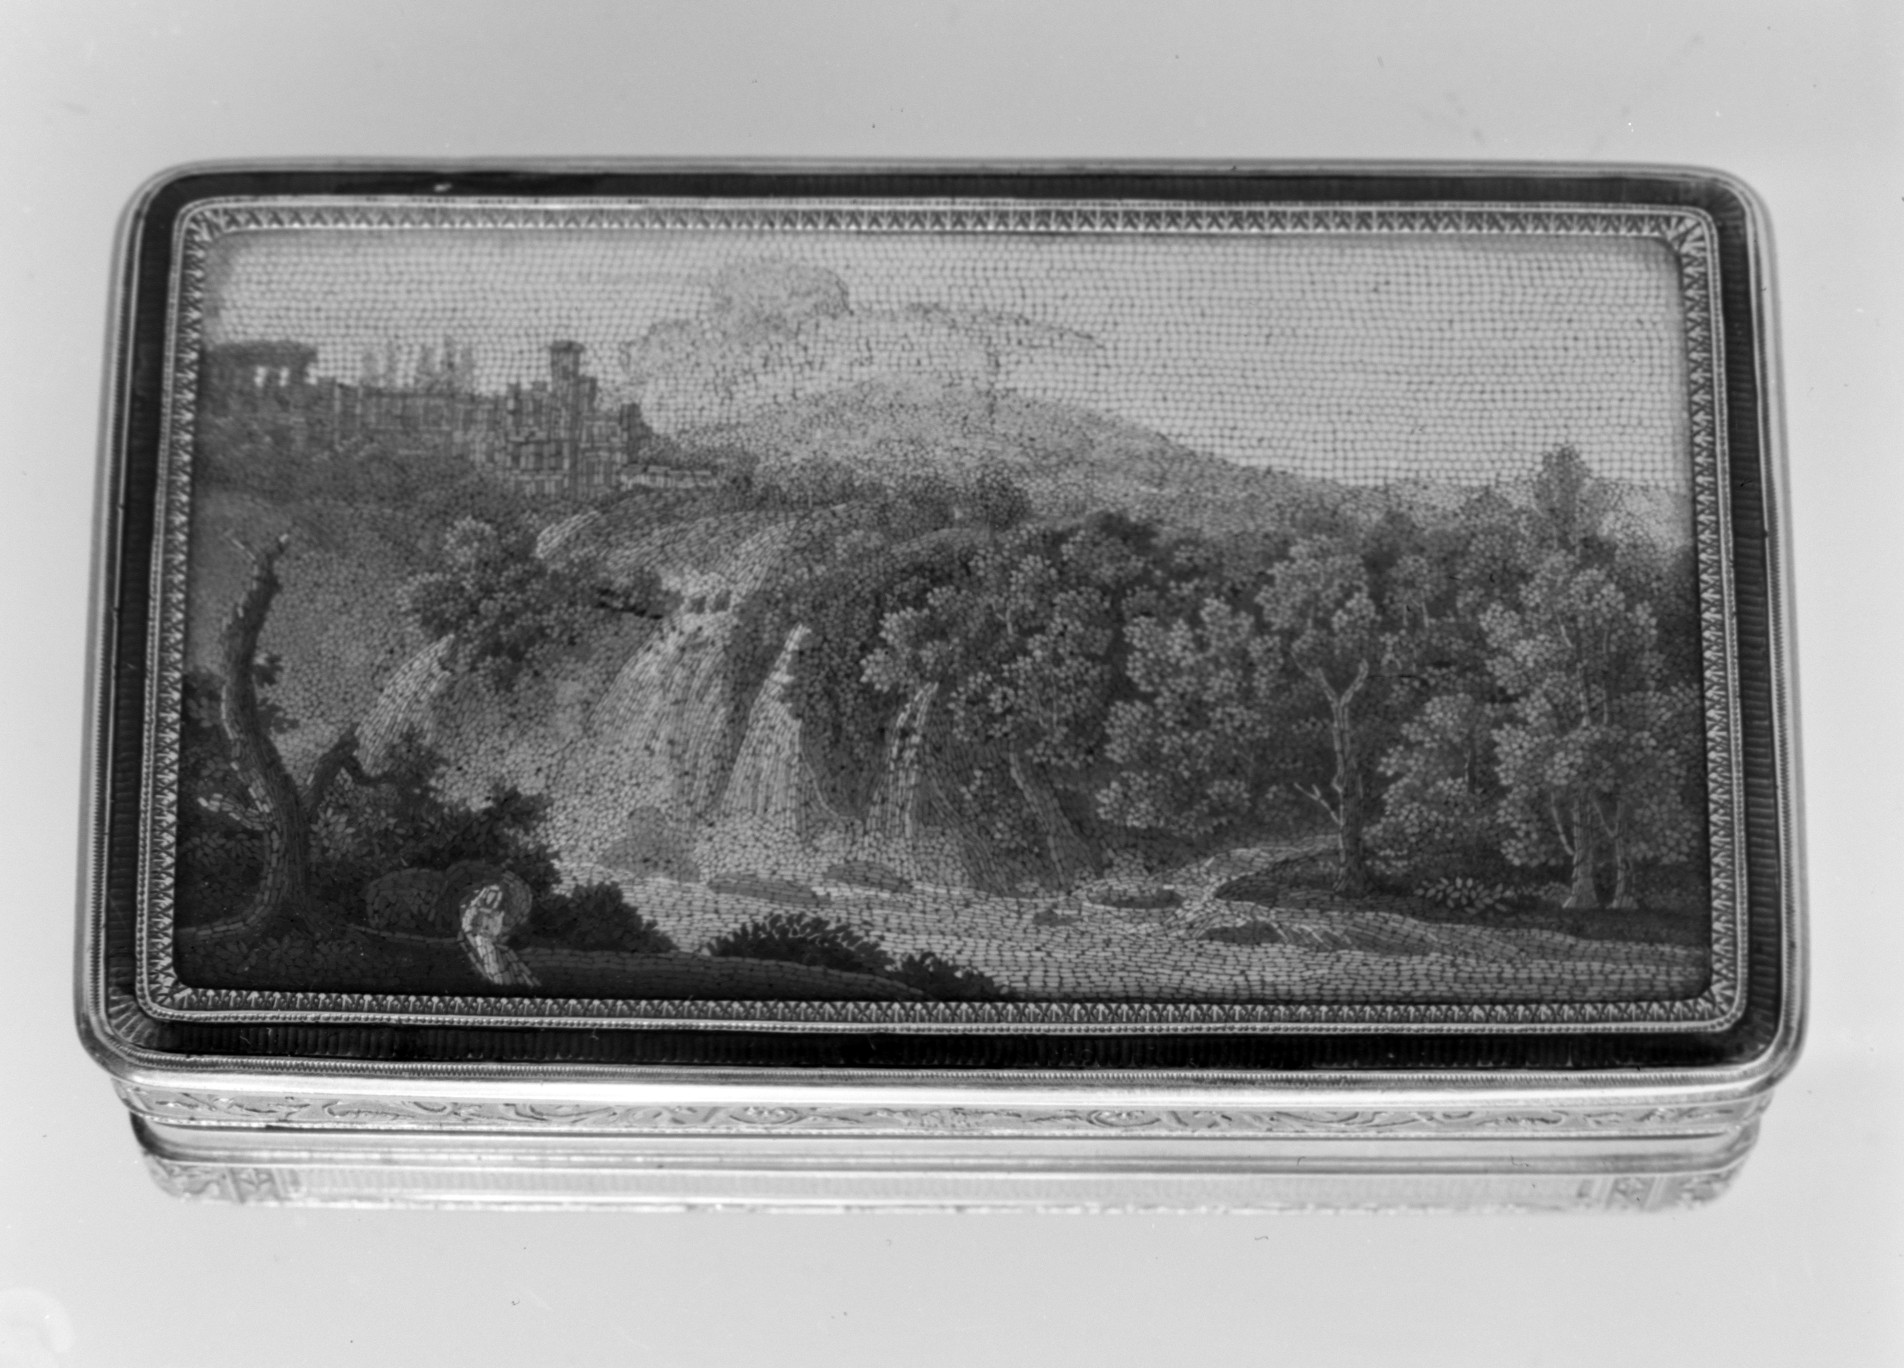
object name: snuffbox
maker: pierre-andré montauban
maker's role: maker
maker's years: 1776-1840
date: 1808-1819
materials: enamel, gold, marble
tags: waterfalls,trees